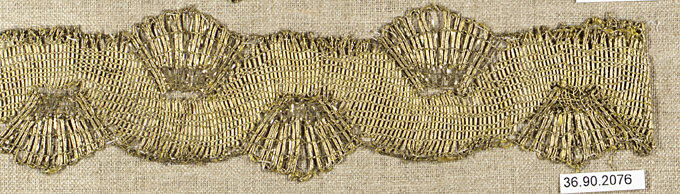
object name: piece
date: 1801-1900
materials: metal thread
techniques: lace